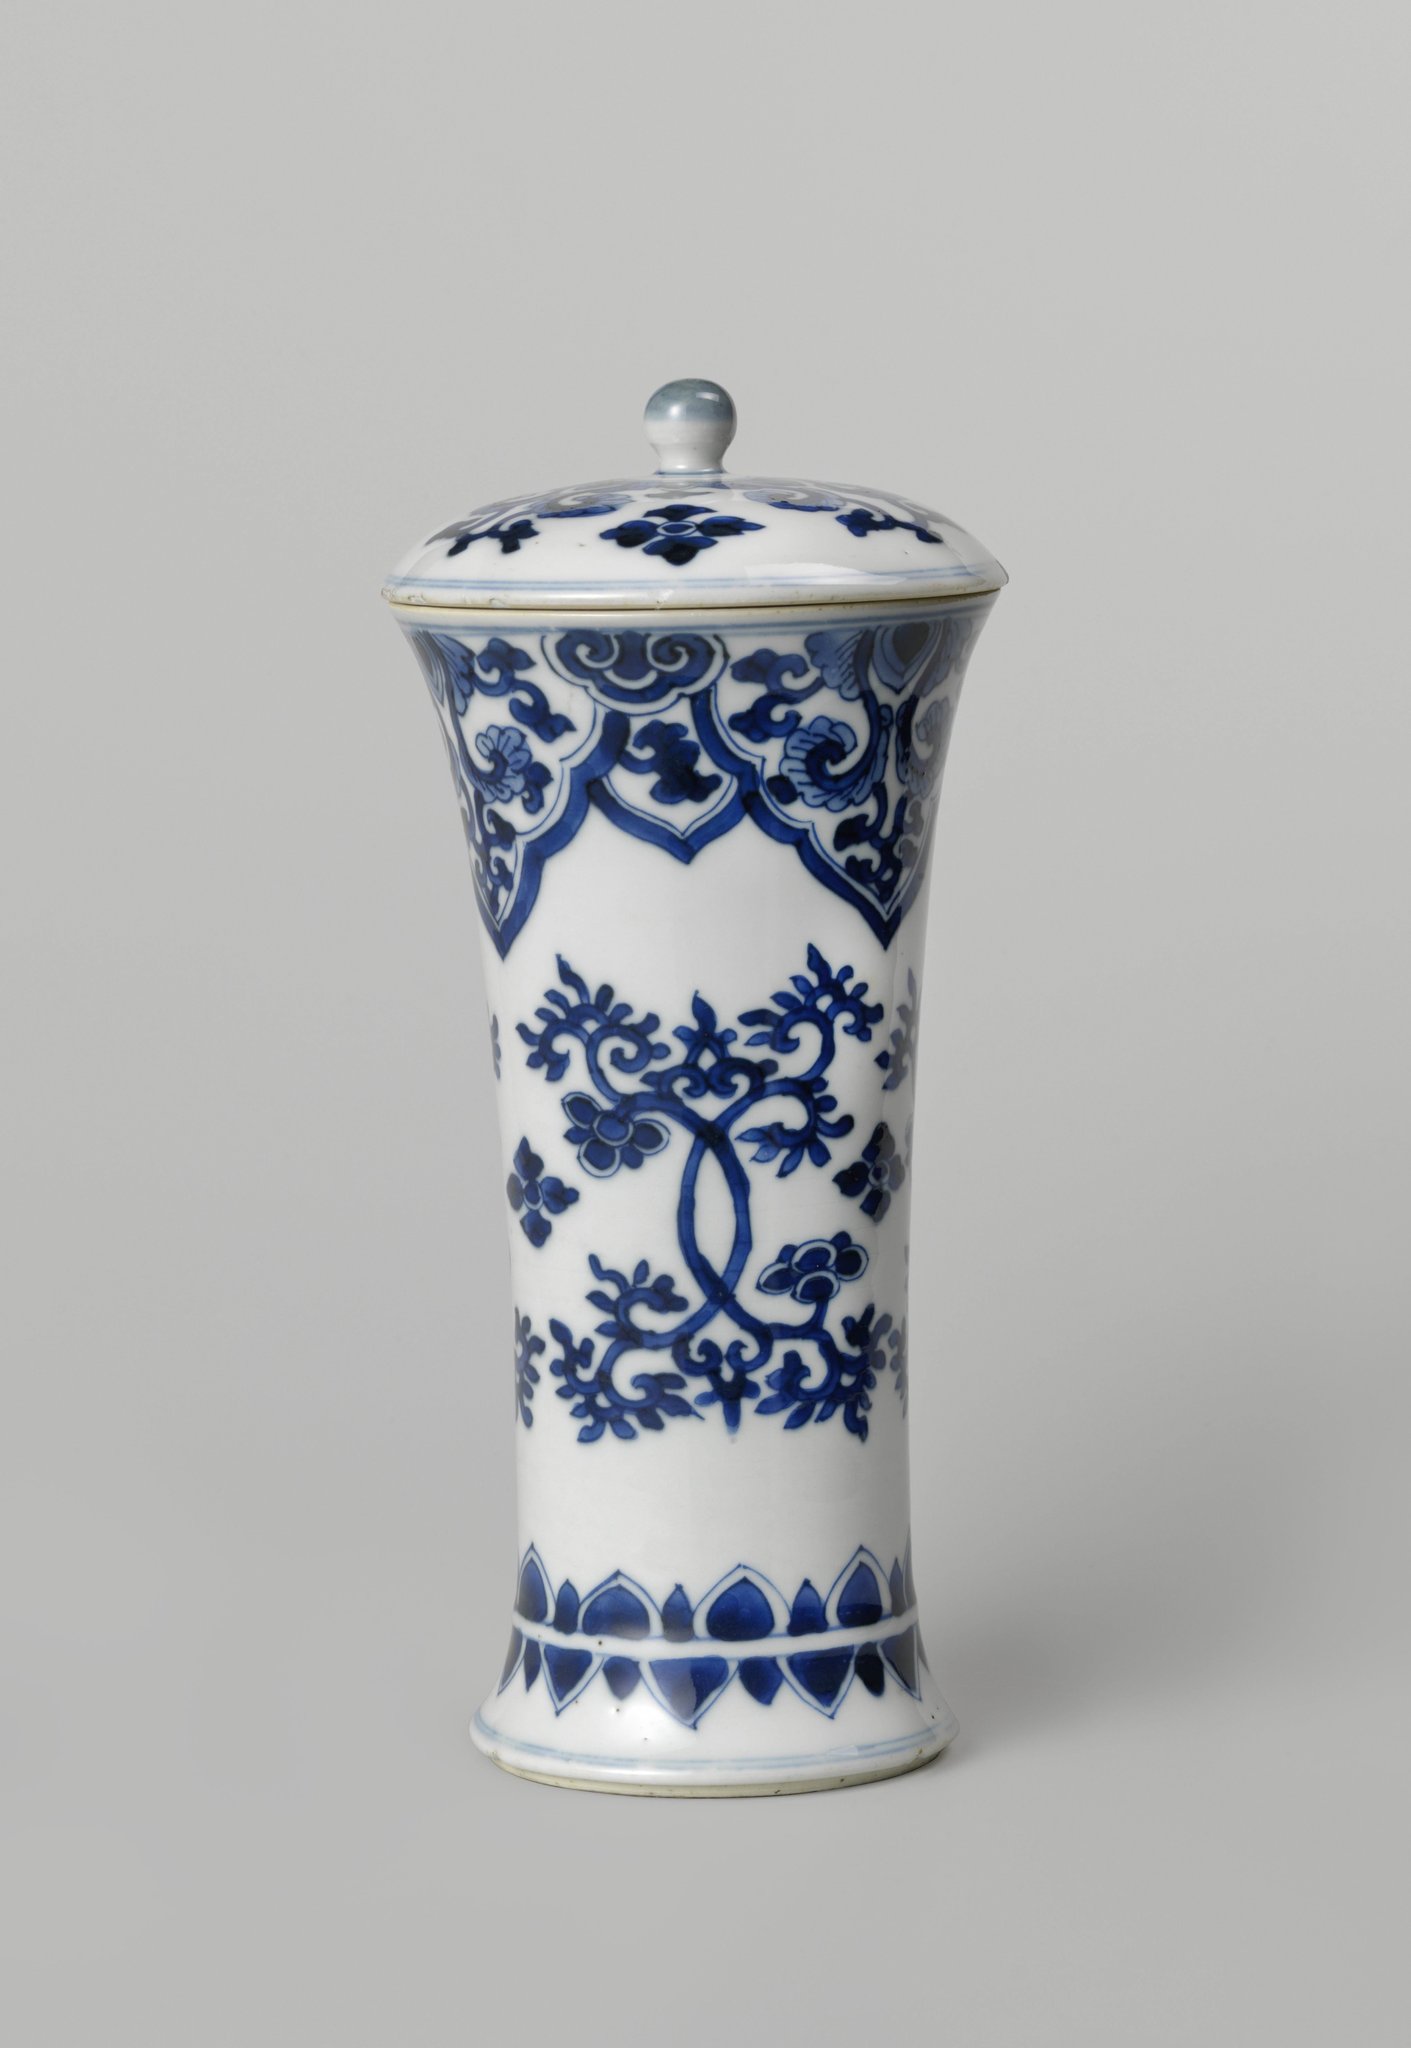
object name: vase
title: Covered cylindrical beaker with flower scrolls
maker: Anonymous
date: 1700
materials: glaze, paint, porcelain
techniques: firing, turning, vitrification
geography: china